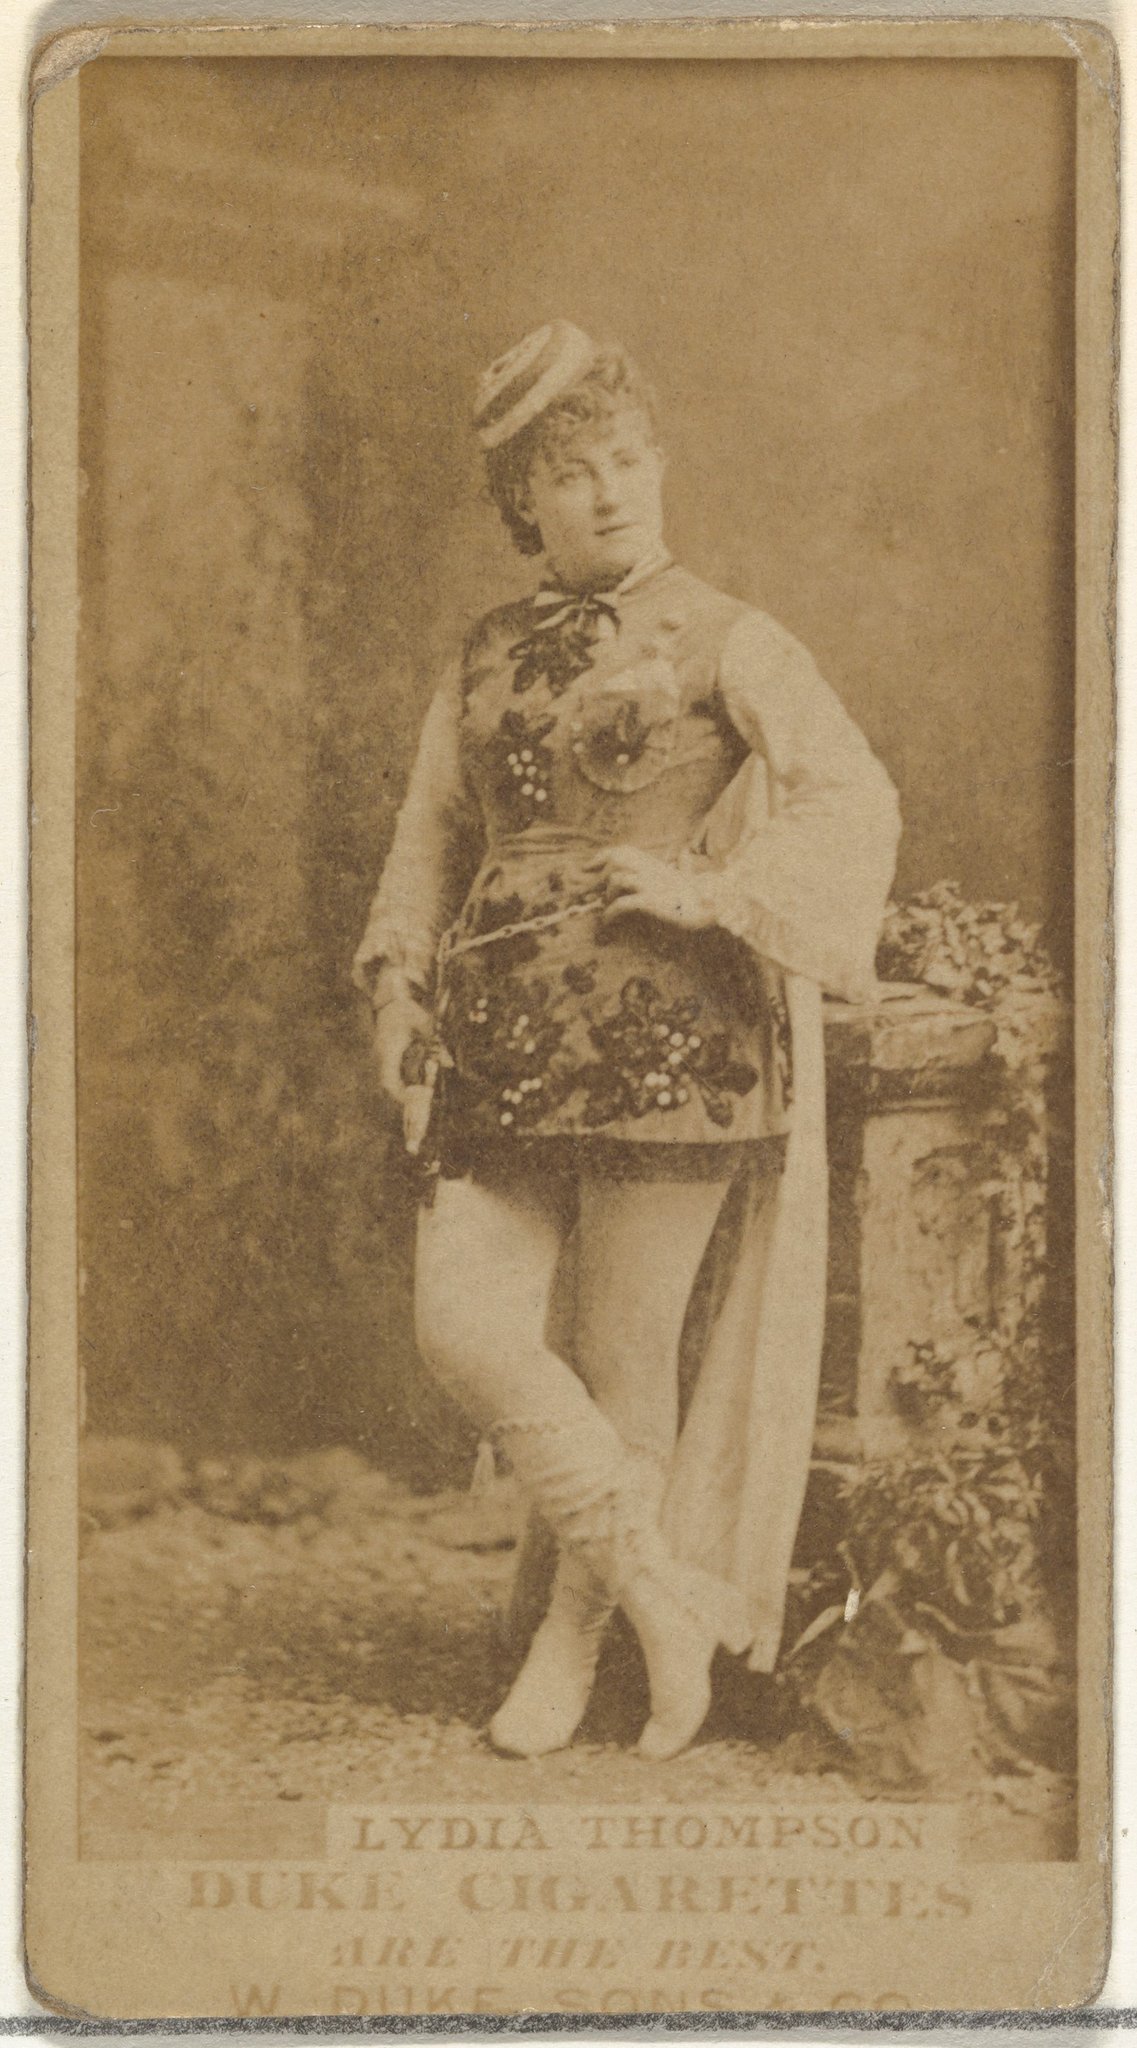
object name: photograph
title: Lydia Thompson, from the Actors and Actresses series (N145-7) issued by Duke Sons & Co. to promote Duke Cigarettes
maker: w. duke, sons & co.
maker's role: publisher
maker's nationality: american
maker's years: 1870-1920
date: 1880-1889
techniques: albumen silver print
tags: portraits,women,actresses